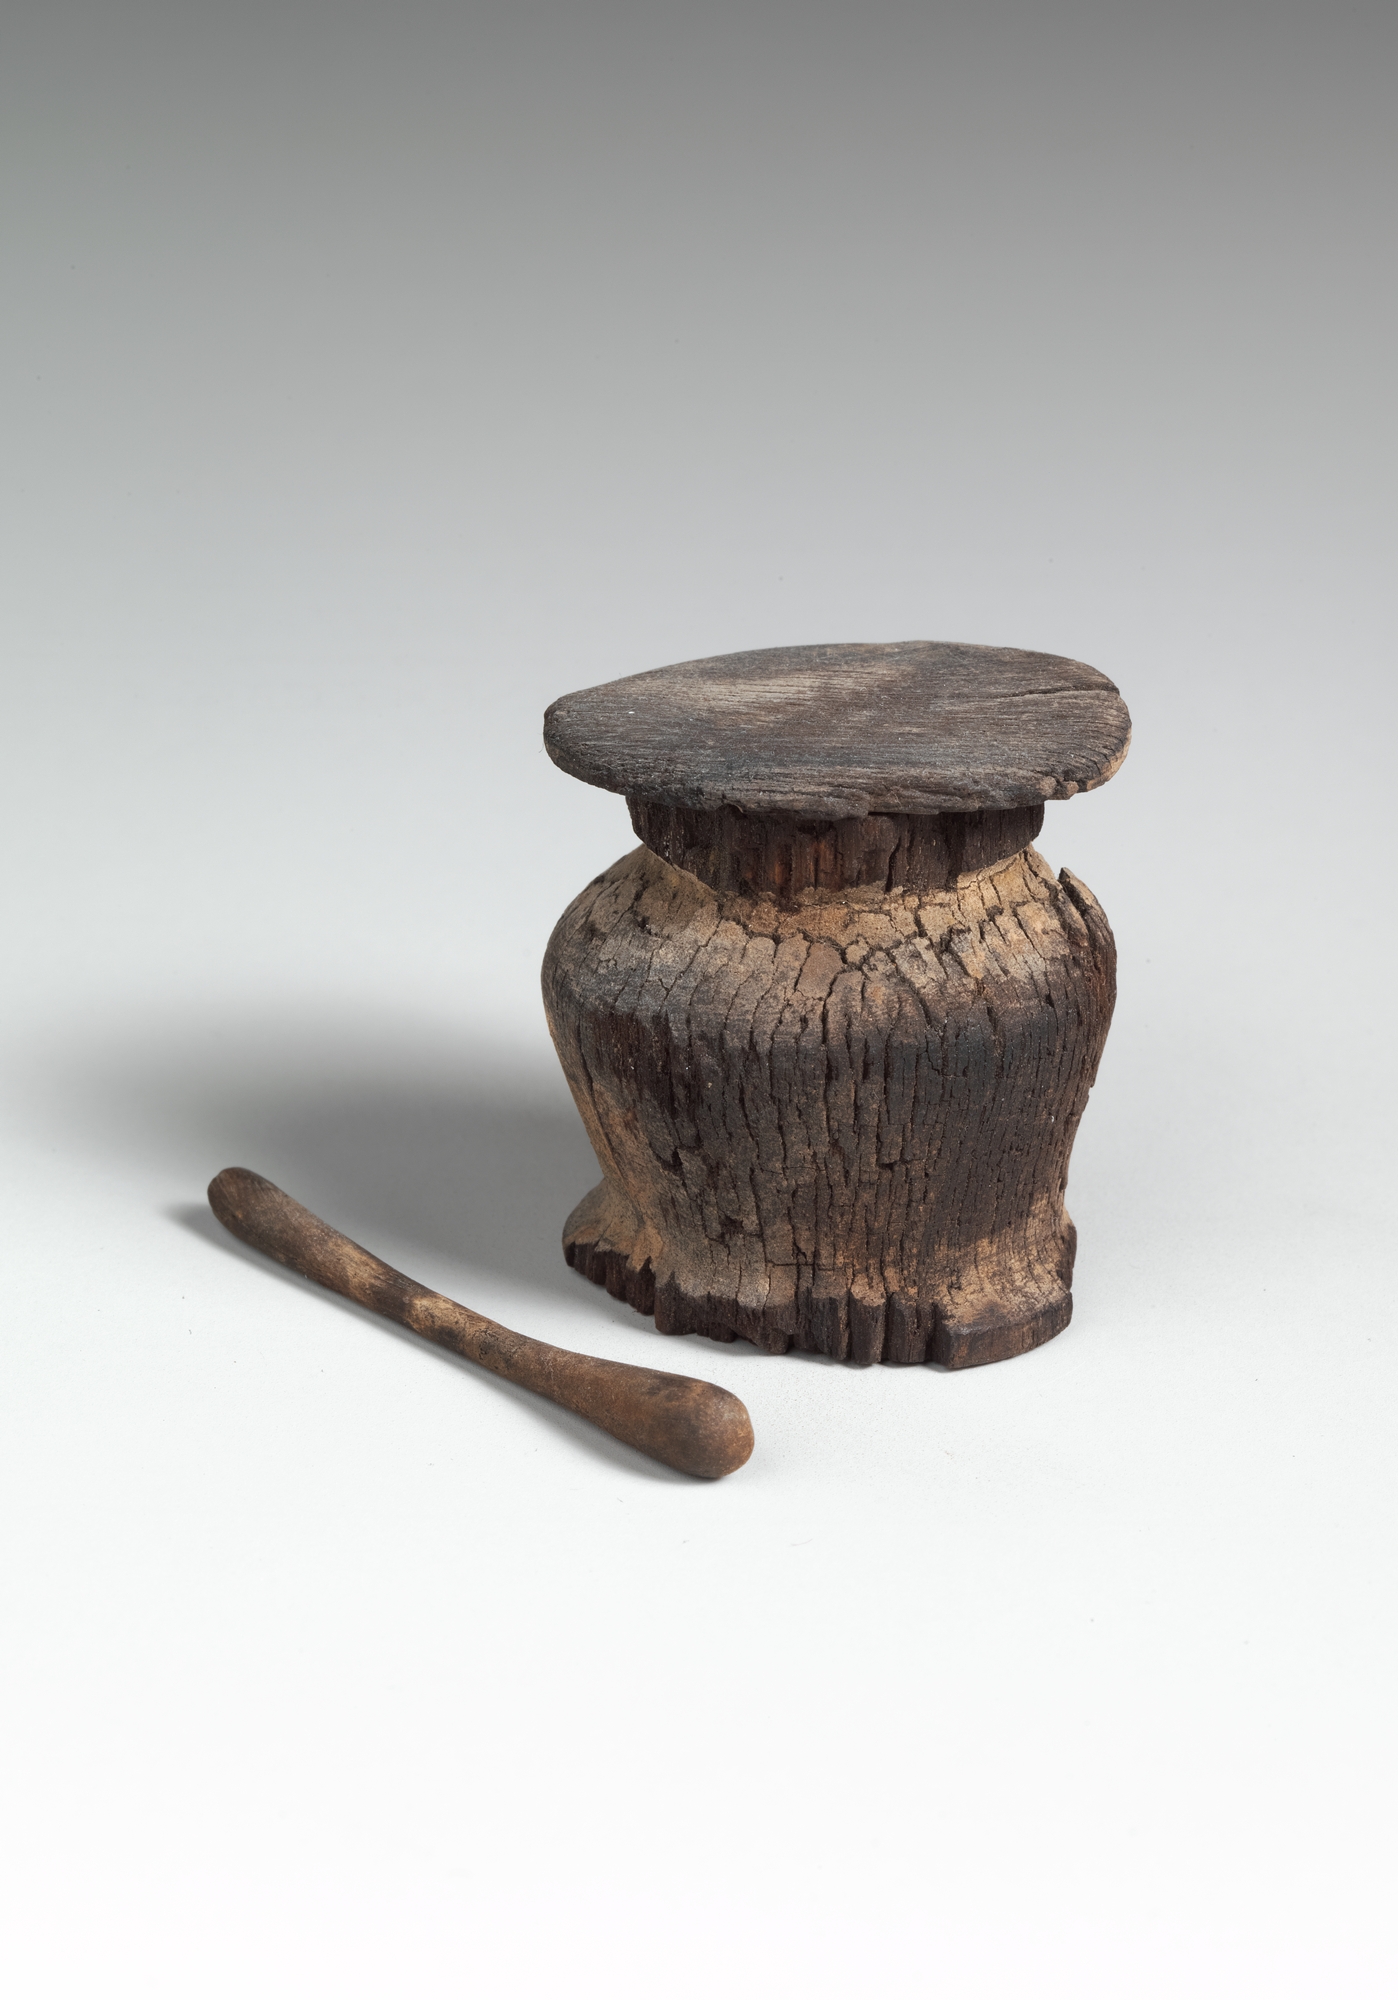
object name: kohl stick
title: Kohl Stick (with Jar 16.10.361a, b)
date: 1635-1458 BCE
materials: paint, wood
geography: egypt